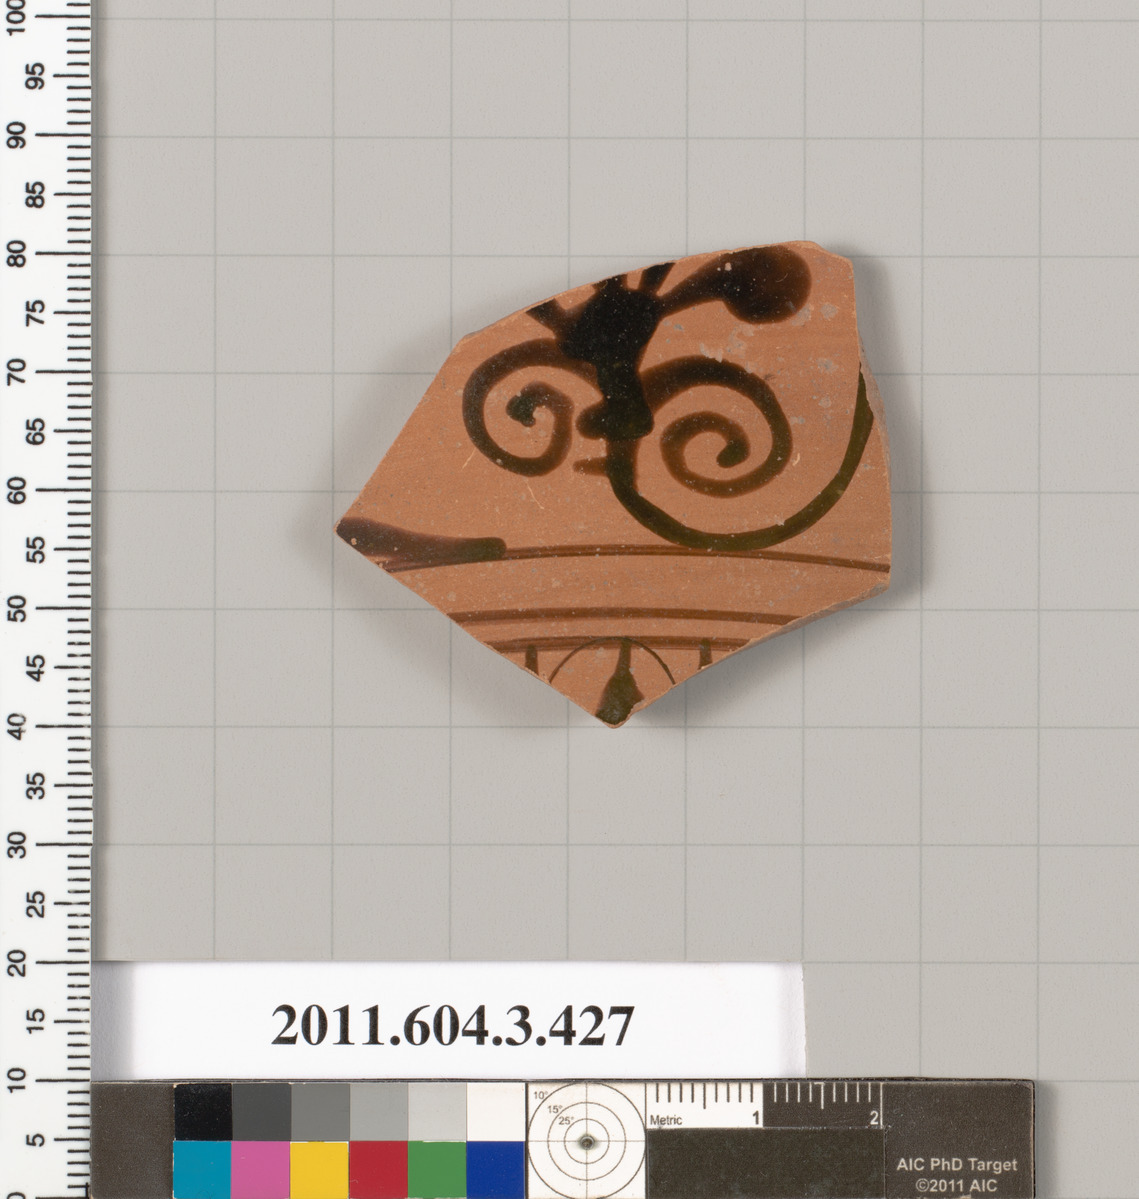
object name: neck amphora fragment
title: Terracotta fragment of a neck-amphora (jar)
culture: greek, attic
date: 520-510 BCE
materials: terracotta